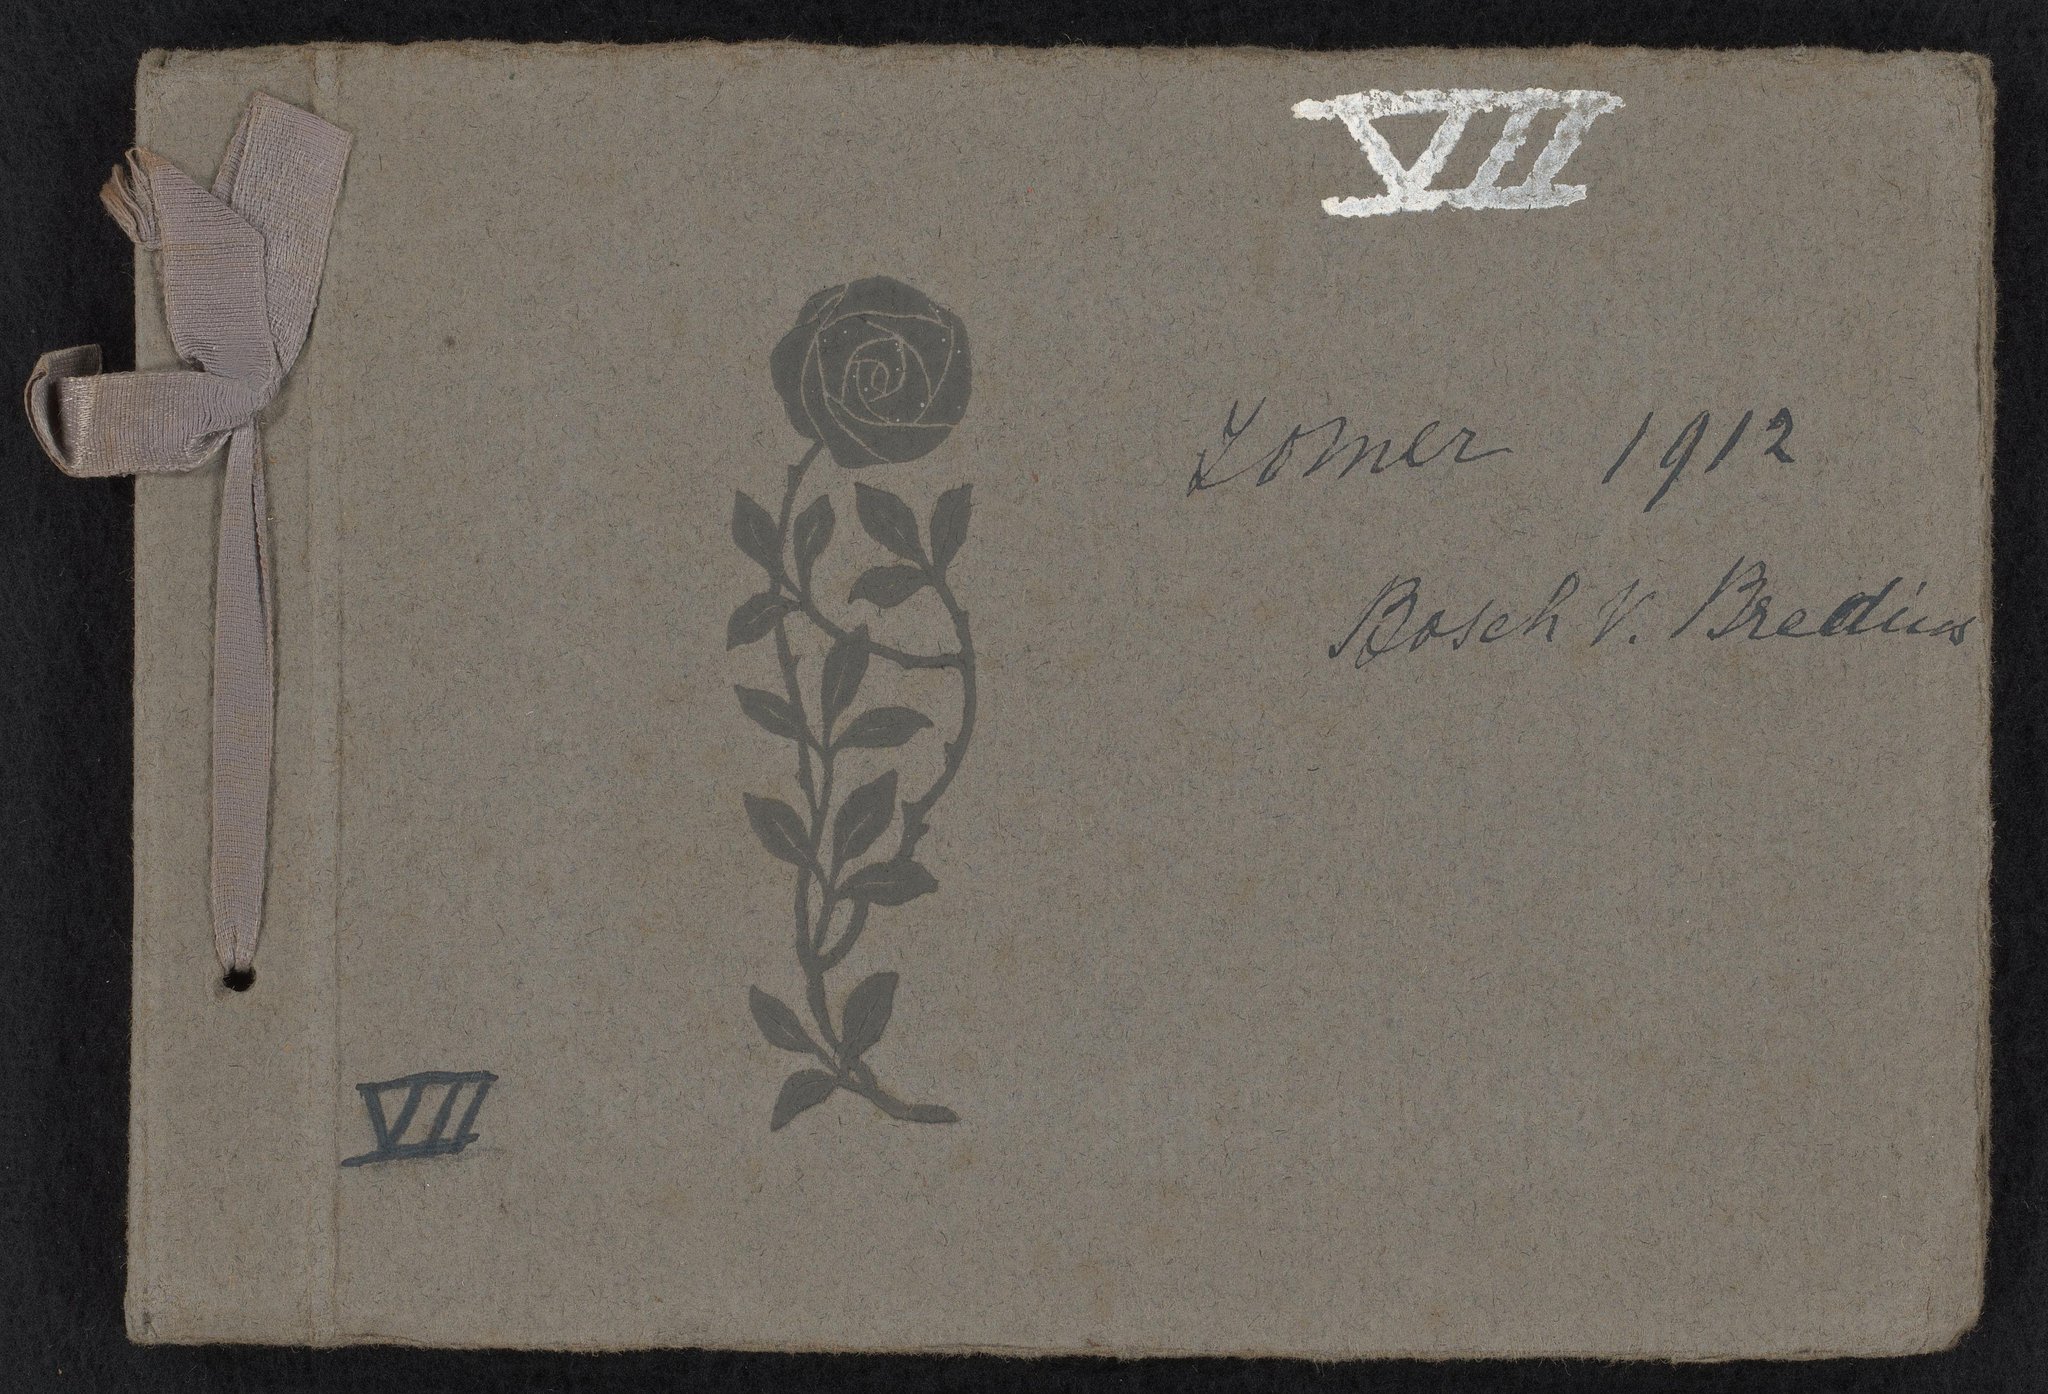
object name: slip in album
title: VII "Zomer 1912 Bosch van Bredius"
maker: hendrik herman van den berg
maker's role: amateurfotograaf, jurist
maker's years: 1875-1944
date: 1908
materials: paper, cardboard, ink, ribbon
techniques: gelatin silver print, pen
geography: naarden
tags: carel frederik van den berg (cay), historical persons, hotel, hostelry, inn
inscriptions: inscription: ‘VII/ Zomer 1912/ Bosch V. Bredius/ VII’, retailer's mark: ‘SCHAAP & CO/ SPUI 8/ AMSTERDAM’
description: Insteekalbum met 18 foto's op 16 bladen. Het album bevat foto's van het verblijf van familie Van den Berg in hotel Bosch van Bredius in Laren. De fotograaf en samensteller is waarschijnlijk Hendrik Herman van den Berg.